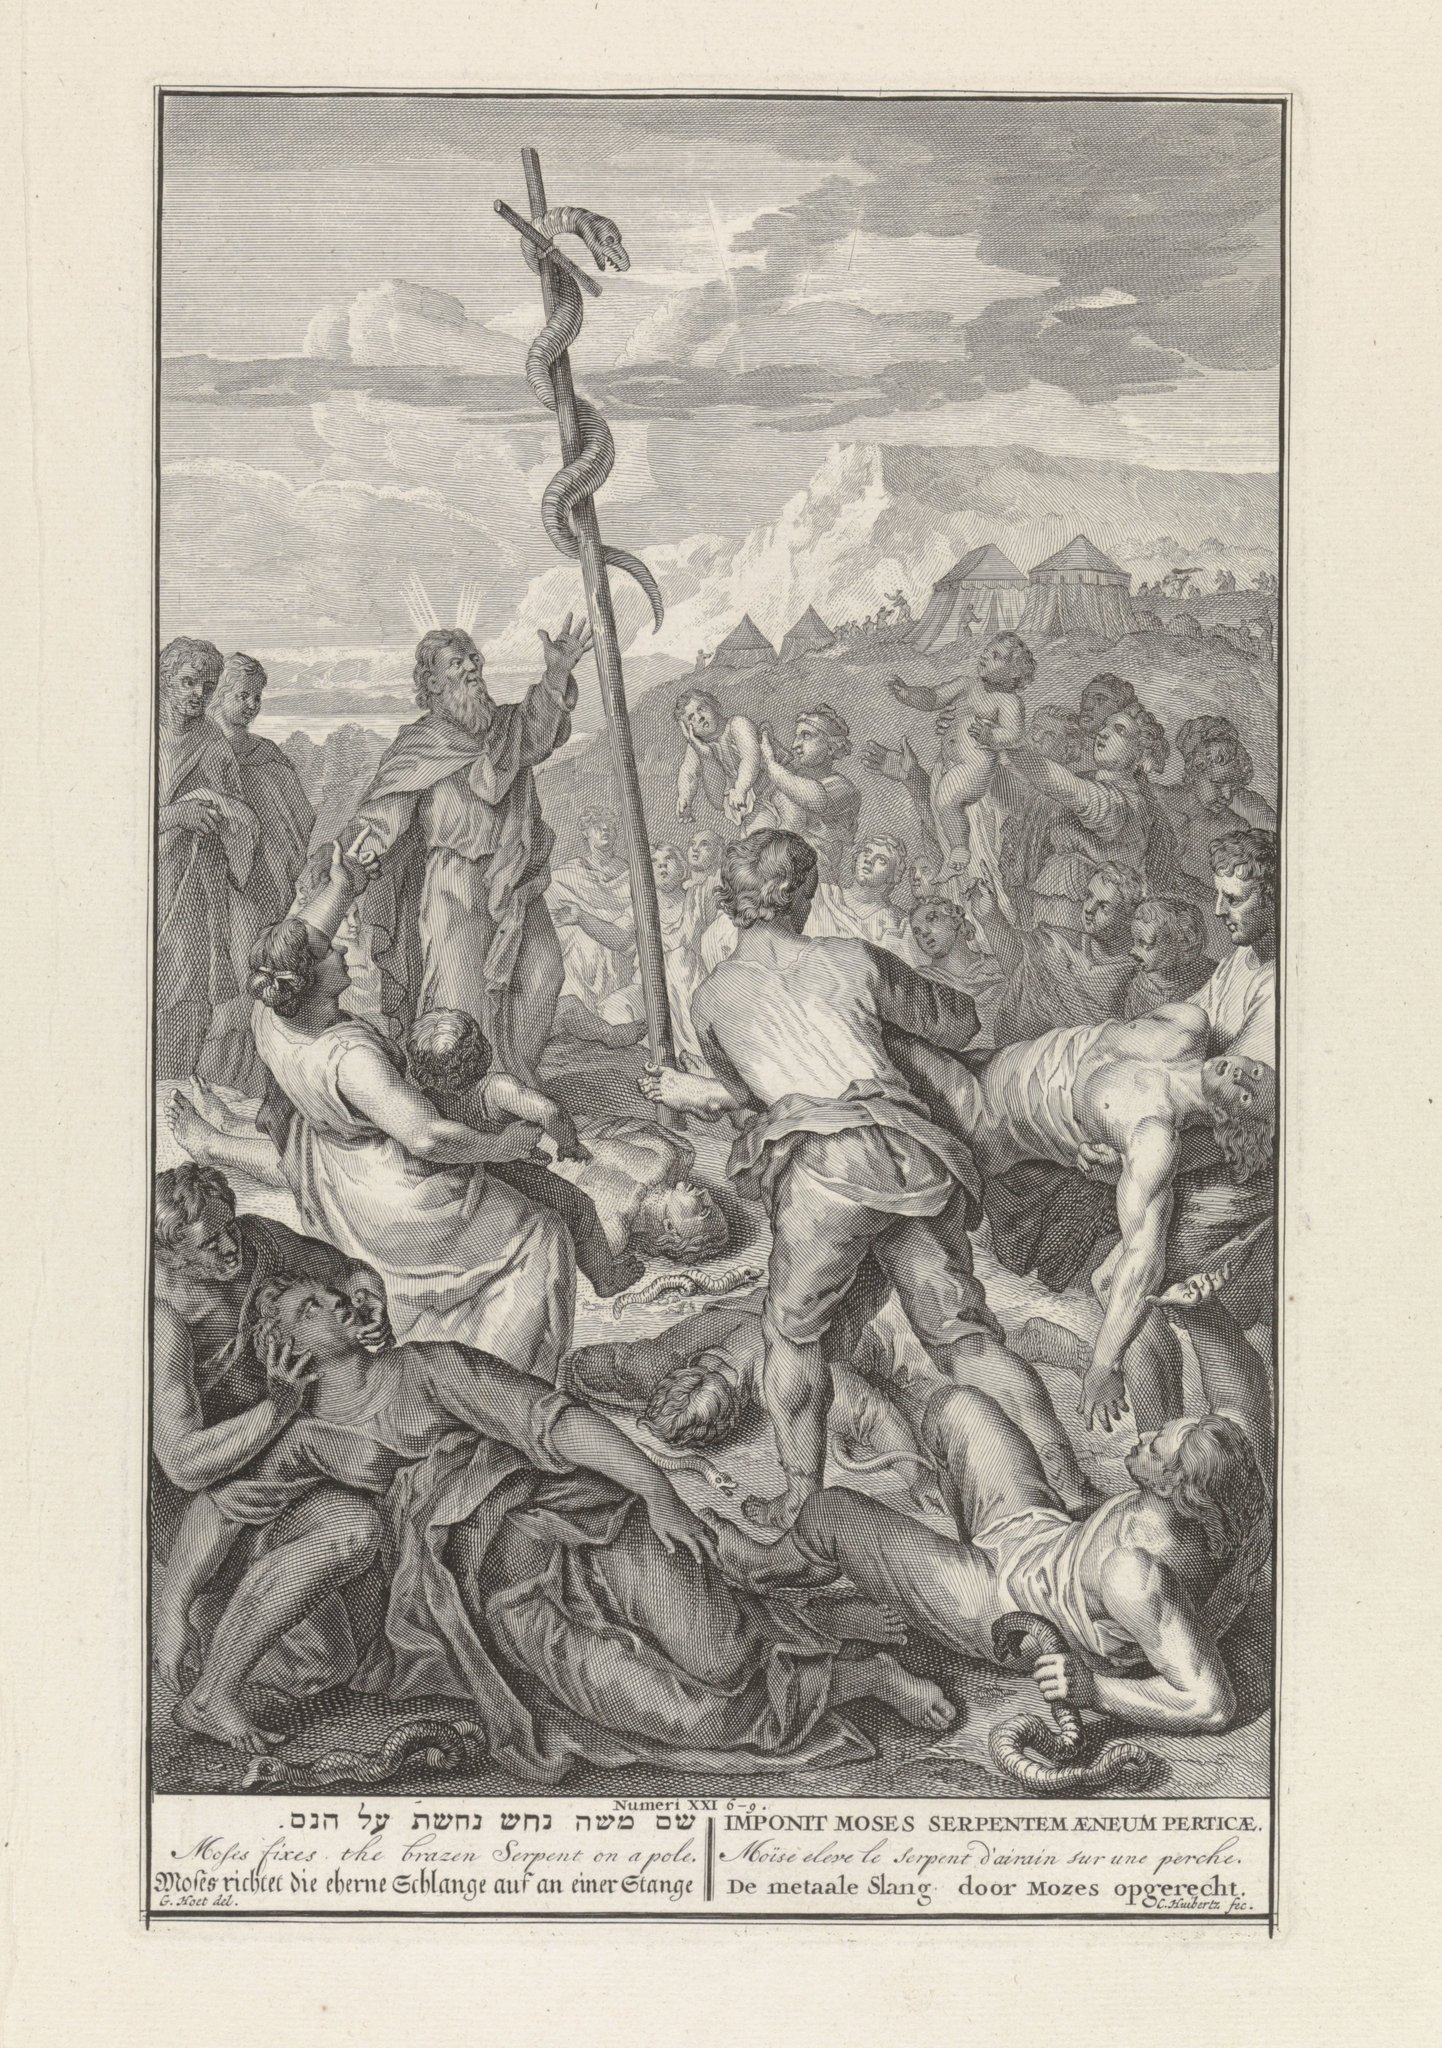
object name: print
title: Mozes en de koperen slang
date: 1720-1728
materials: paper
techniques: engraving, etching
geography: amsterdam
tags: anyone who is bitten by a snake is cured by looking at the brazen serpent; the serpent (or dragon) is usually depicted on a tau-shaped cross or on a pillar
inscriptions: collector's mark: Lugt 2228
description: Naast Mozes staat de koperen slang, bevestigd op een staak. De Israelieten die door slangen zijn gebeten staan er omheen en kijken ernaar, als middel om in leven te blijven. Rechtsachter het tentenkamp van de Israëlieten. Onder een verwijzing naar Num. 21:6-9 en de titel van de prent in Hebreeuws, Engels, Duits, Latijn, Frans en Nederlands.